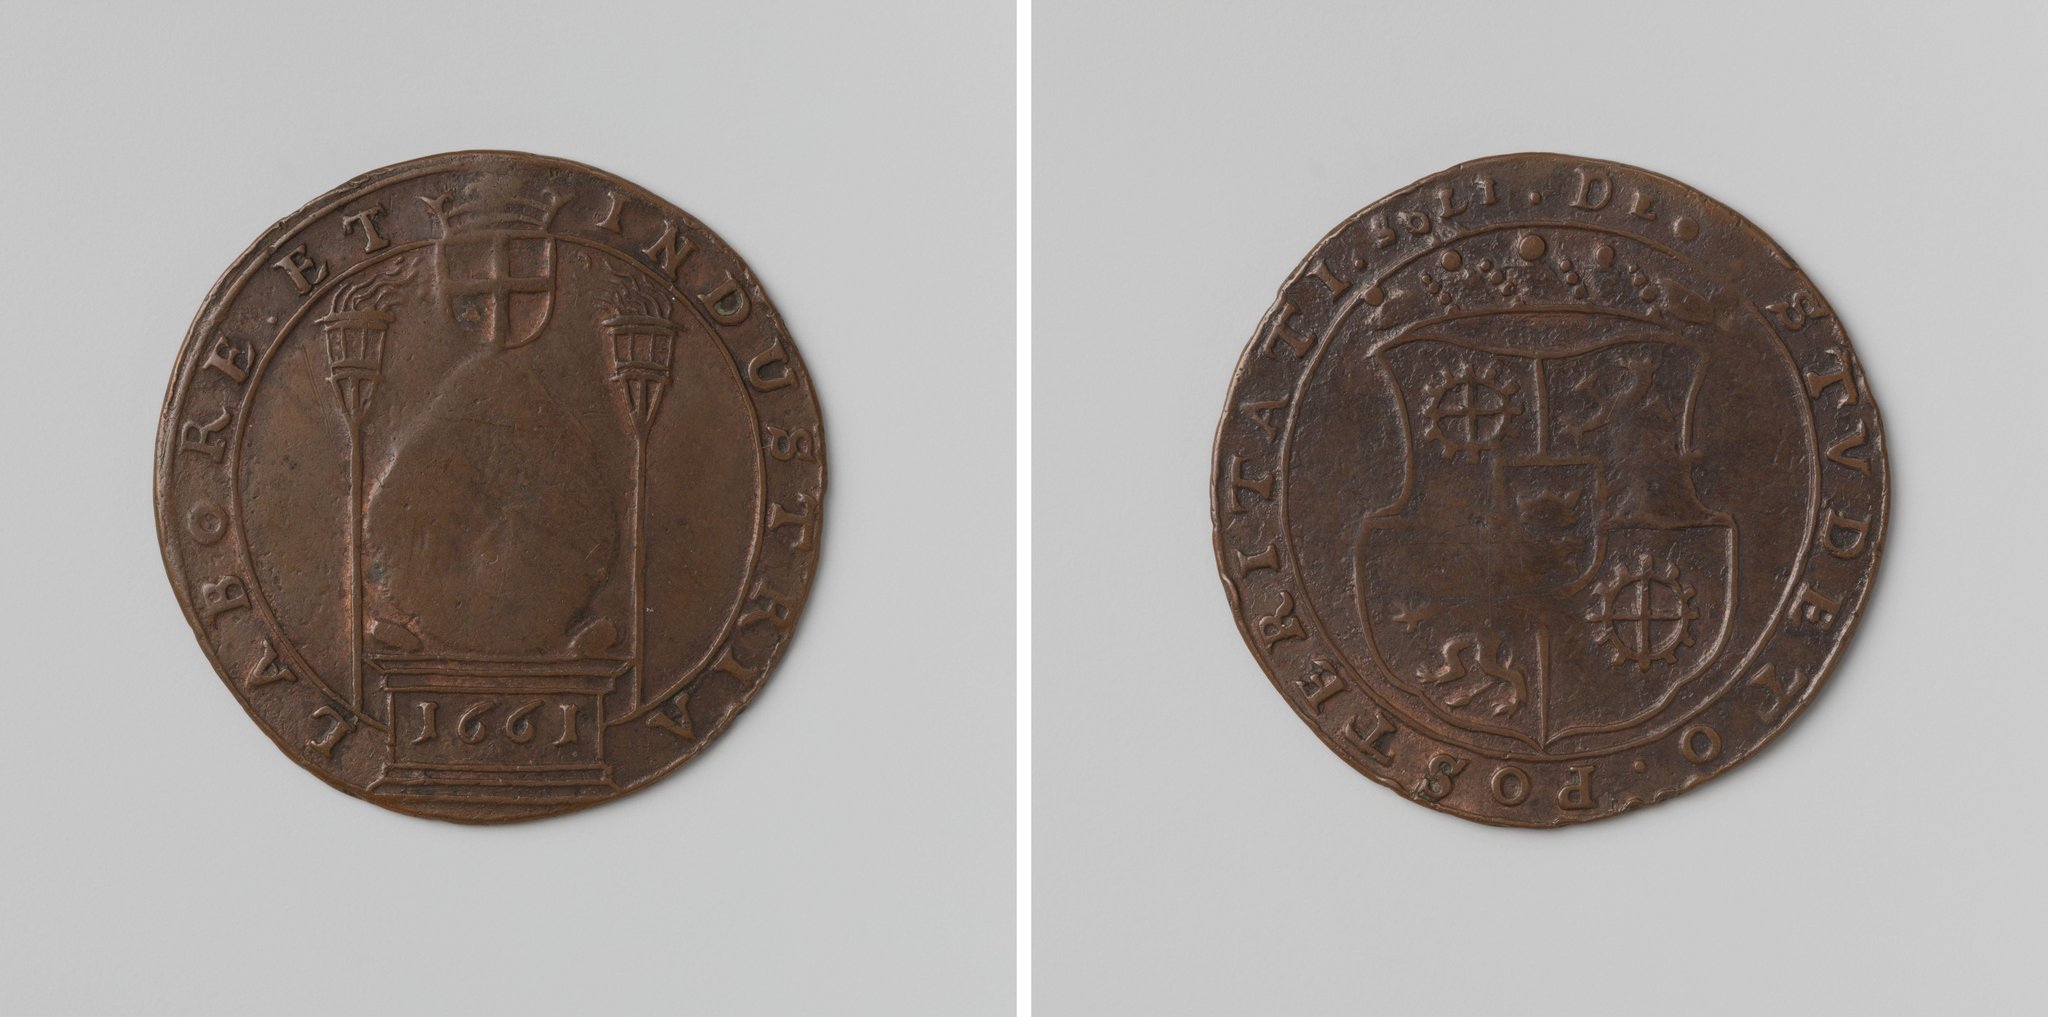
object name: jeton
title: Verplaatsen van een grote zwerfkei van de Waelberch (bij De Stompert) naar Amersfoort, rekenpenning geslagen op last van de stad Amersfoort ter ere van jonkheer Everard Meyster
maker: Anonymous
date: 1661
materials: copper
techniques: striking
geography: netherlands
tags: utrecht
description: Koperen penning. Voorzijde: grote steen, staande tussen twee brandende toortsen op sokkel met opschrift onder gekroond wapenschild binnen omschrift. Keerzijde: gekroond wapenschild binnen omschrift.